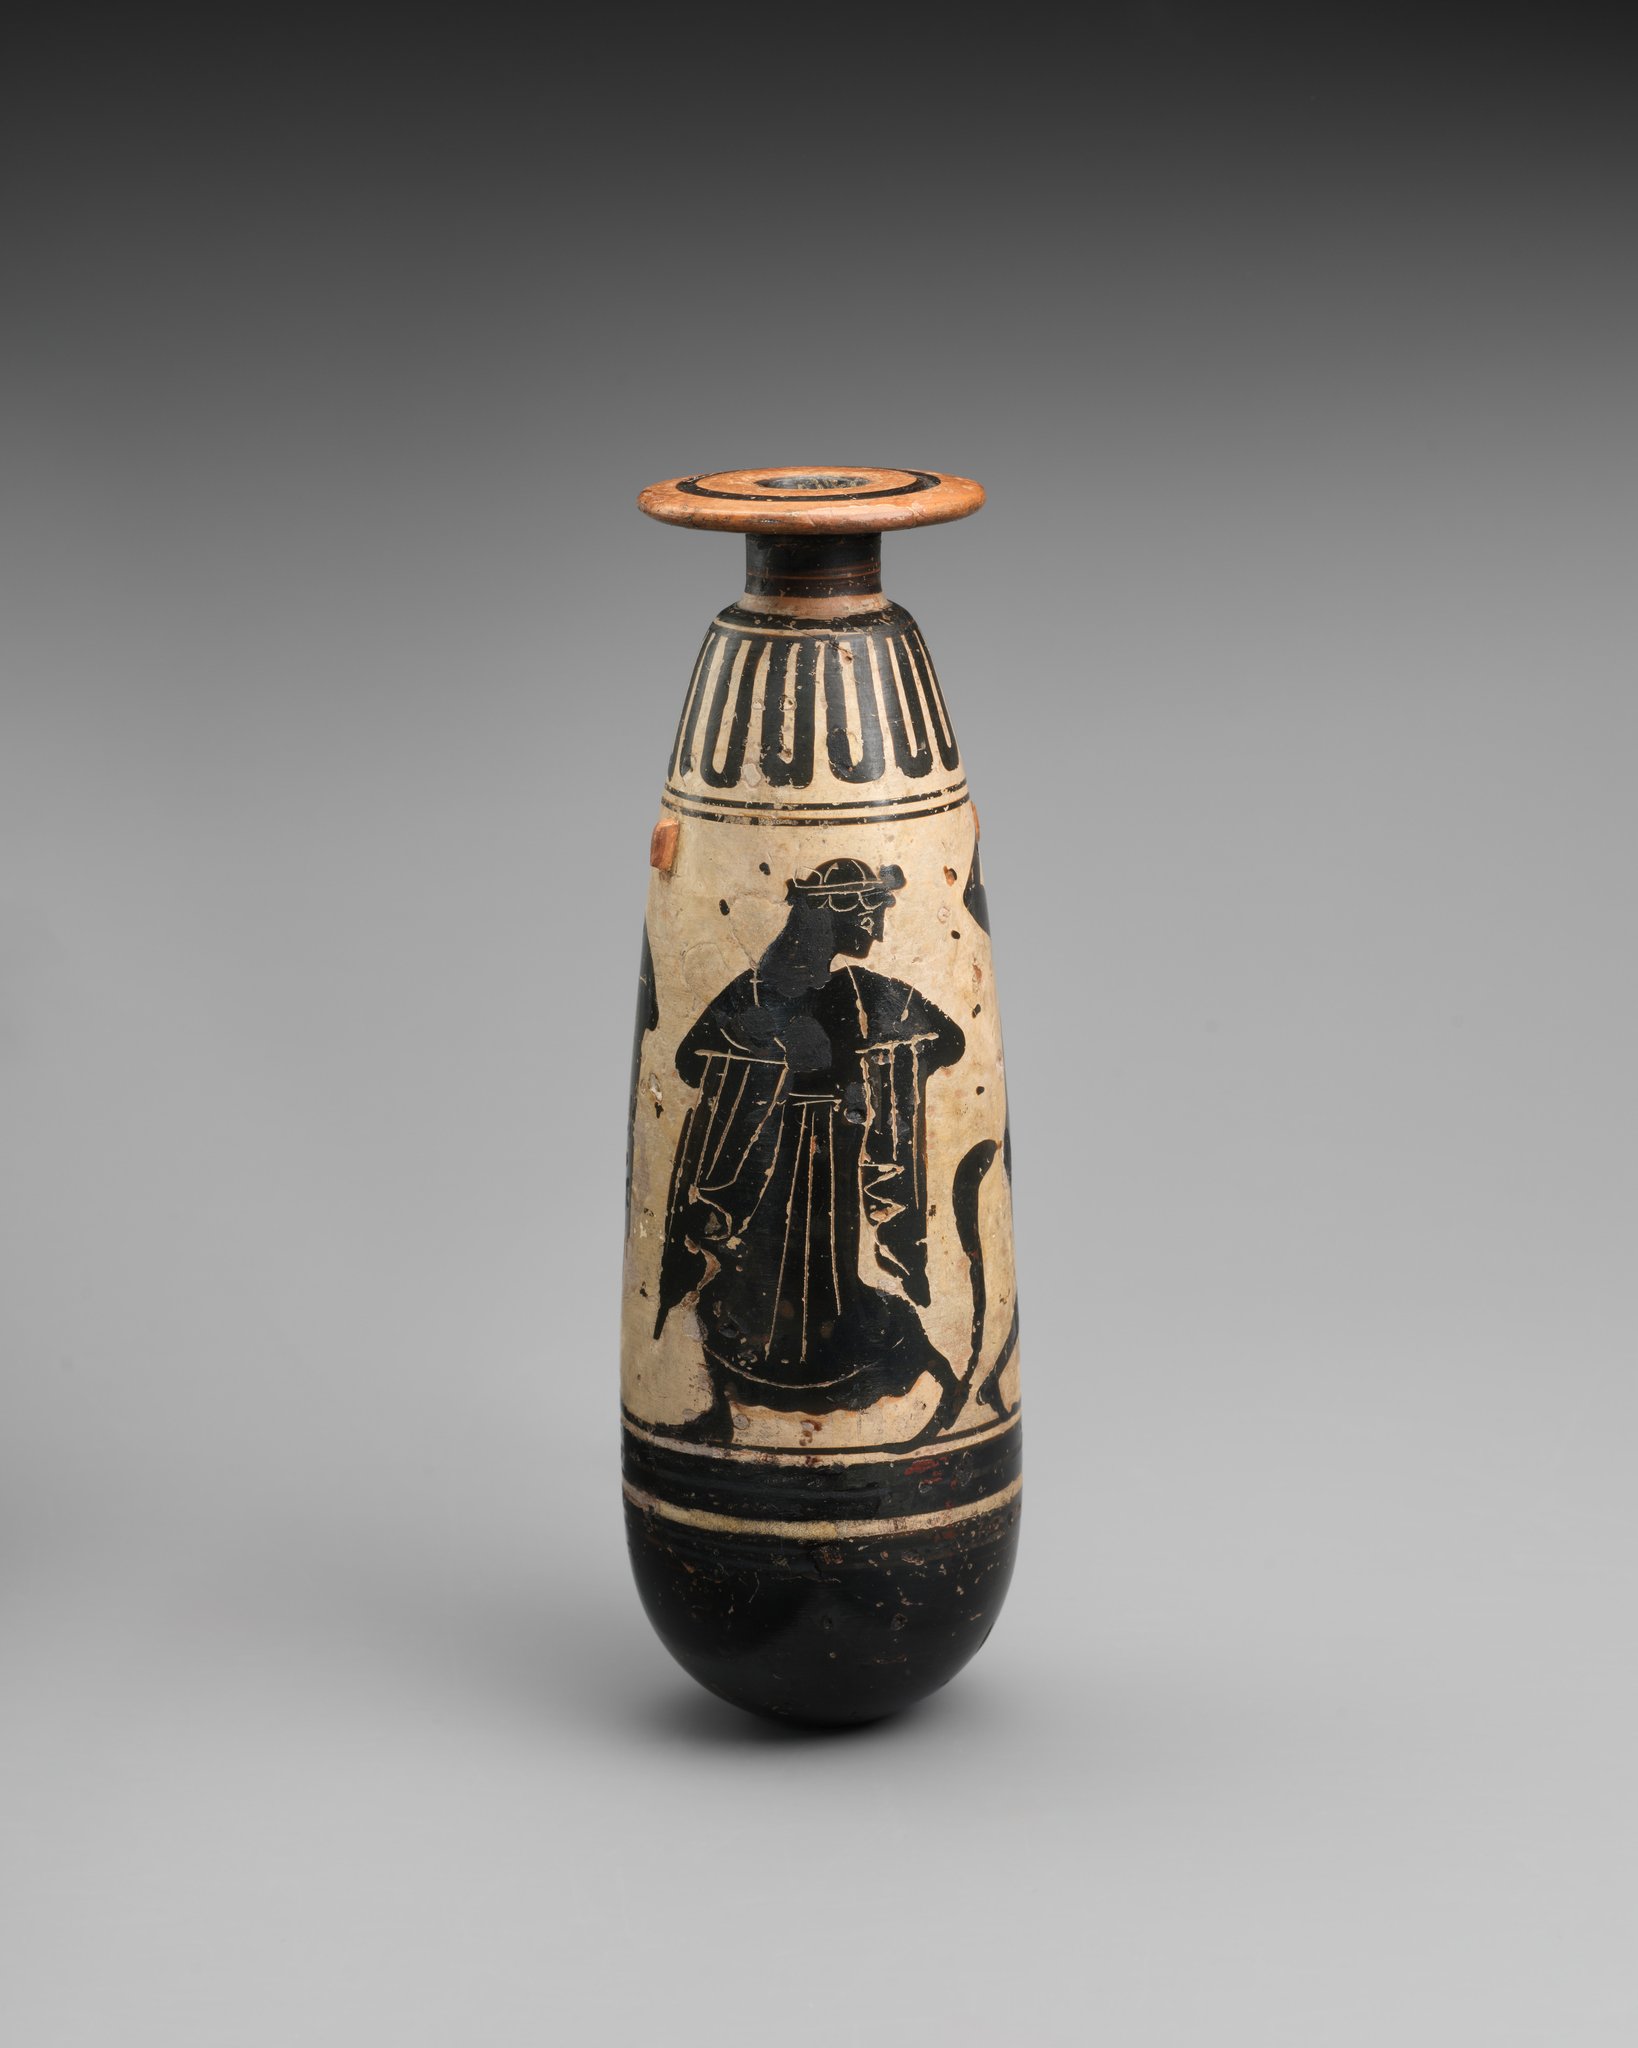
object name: alabastron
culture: greek, attic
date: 500 BCE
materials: terracotta